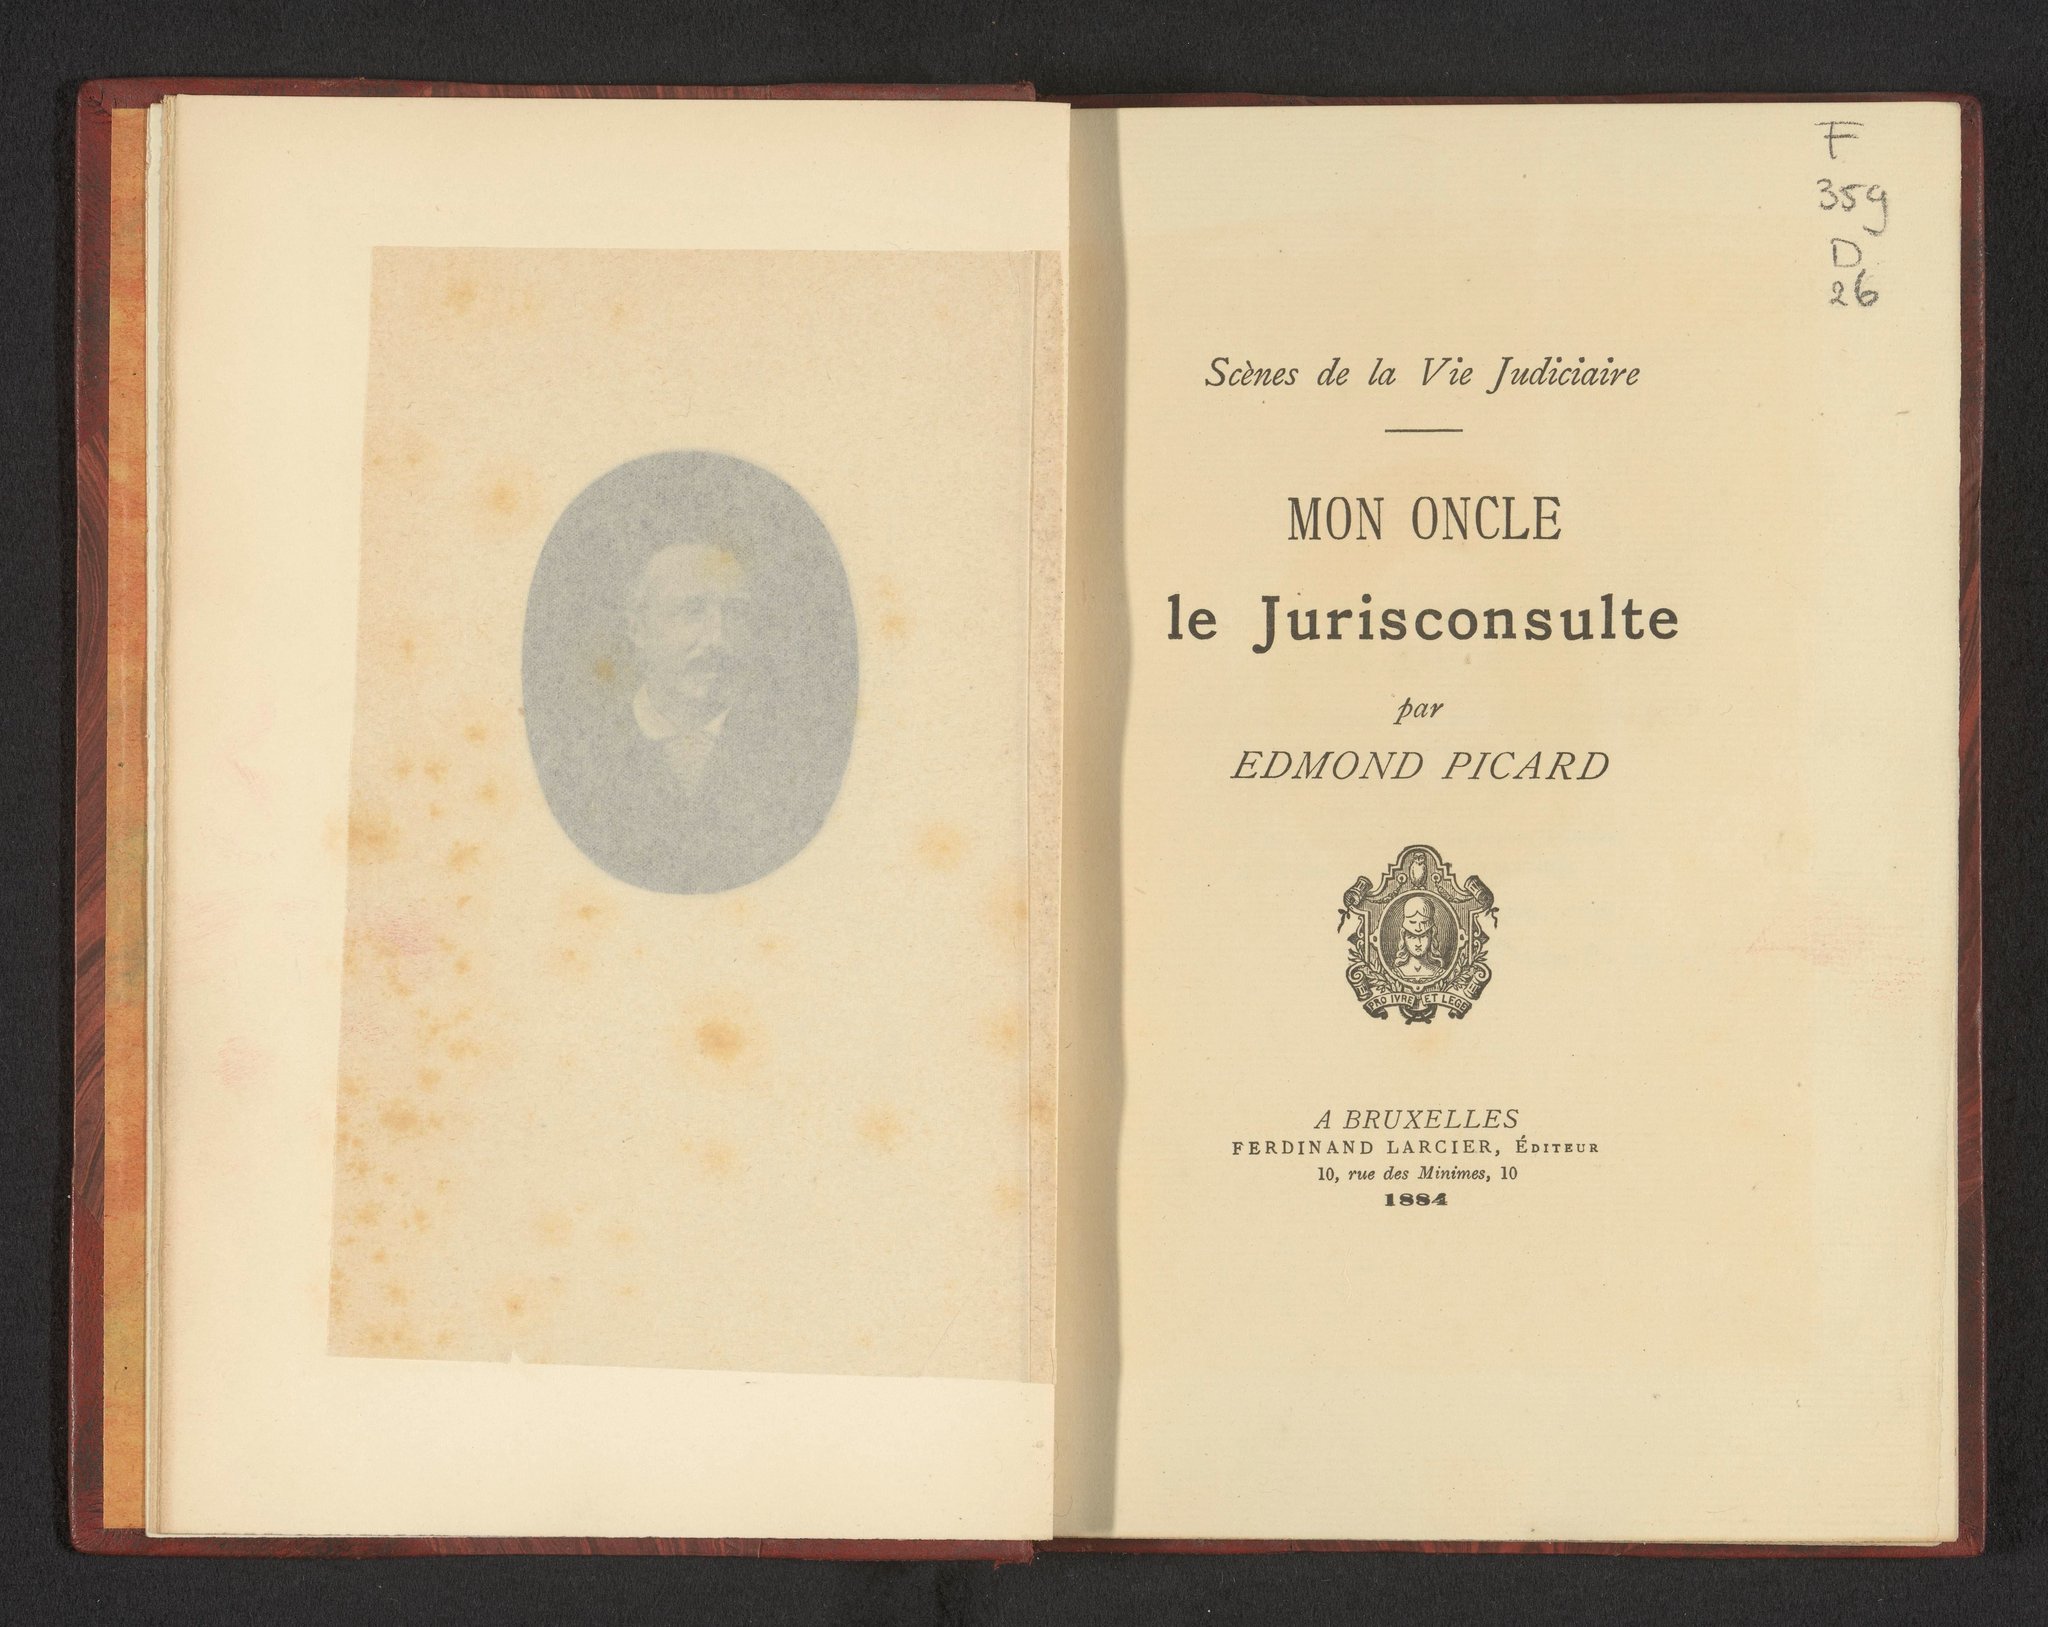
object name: book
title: Mon oncle le jurisconsulte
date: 1884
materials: linen, paper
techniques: photograph, printing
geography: brussels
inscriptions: date: ‘Nov 1988’, annotation: ‘E.O. 400-’